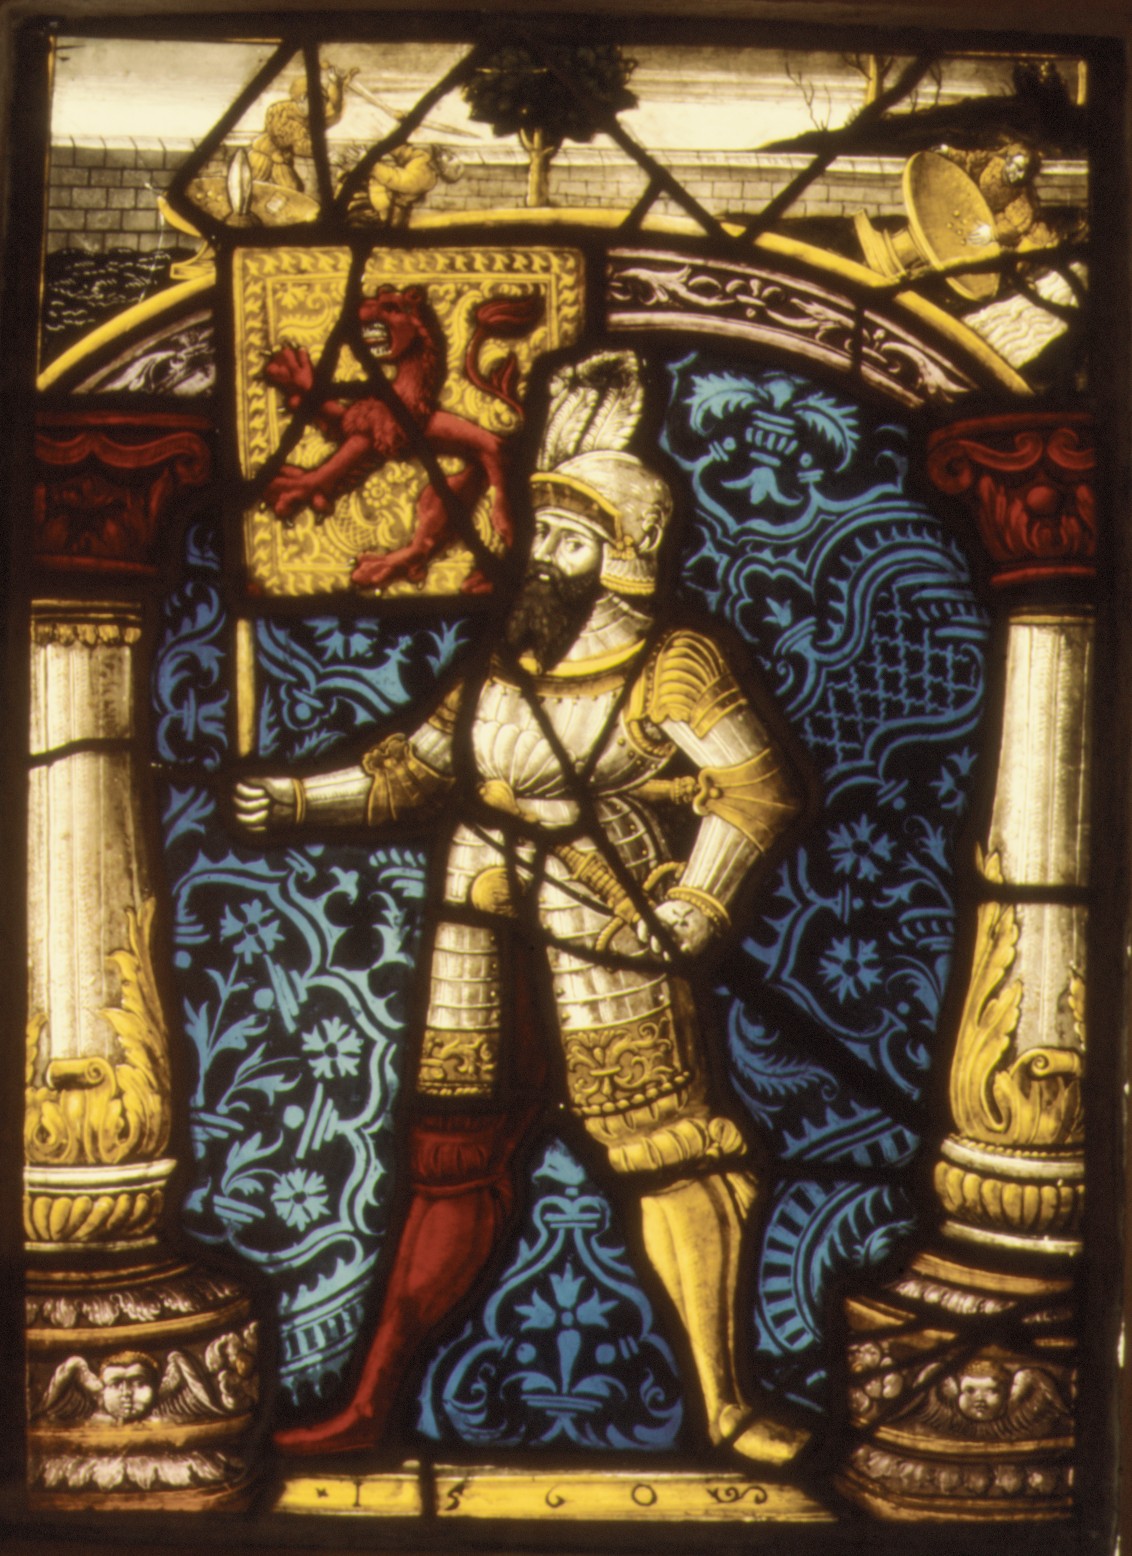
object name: panel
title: Ensign with flag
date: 1560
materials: glass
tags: men,lions,flags